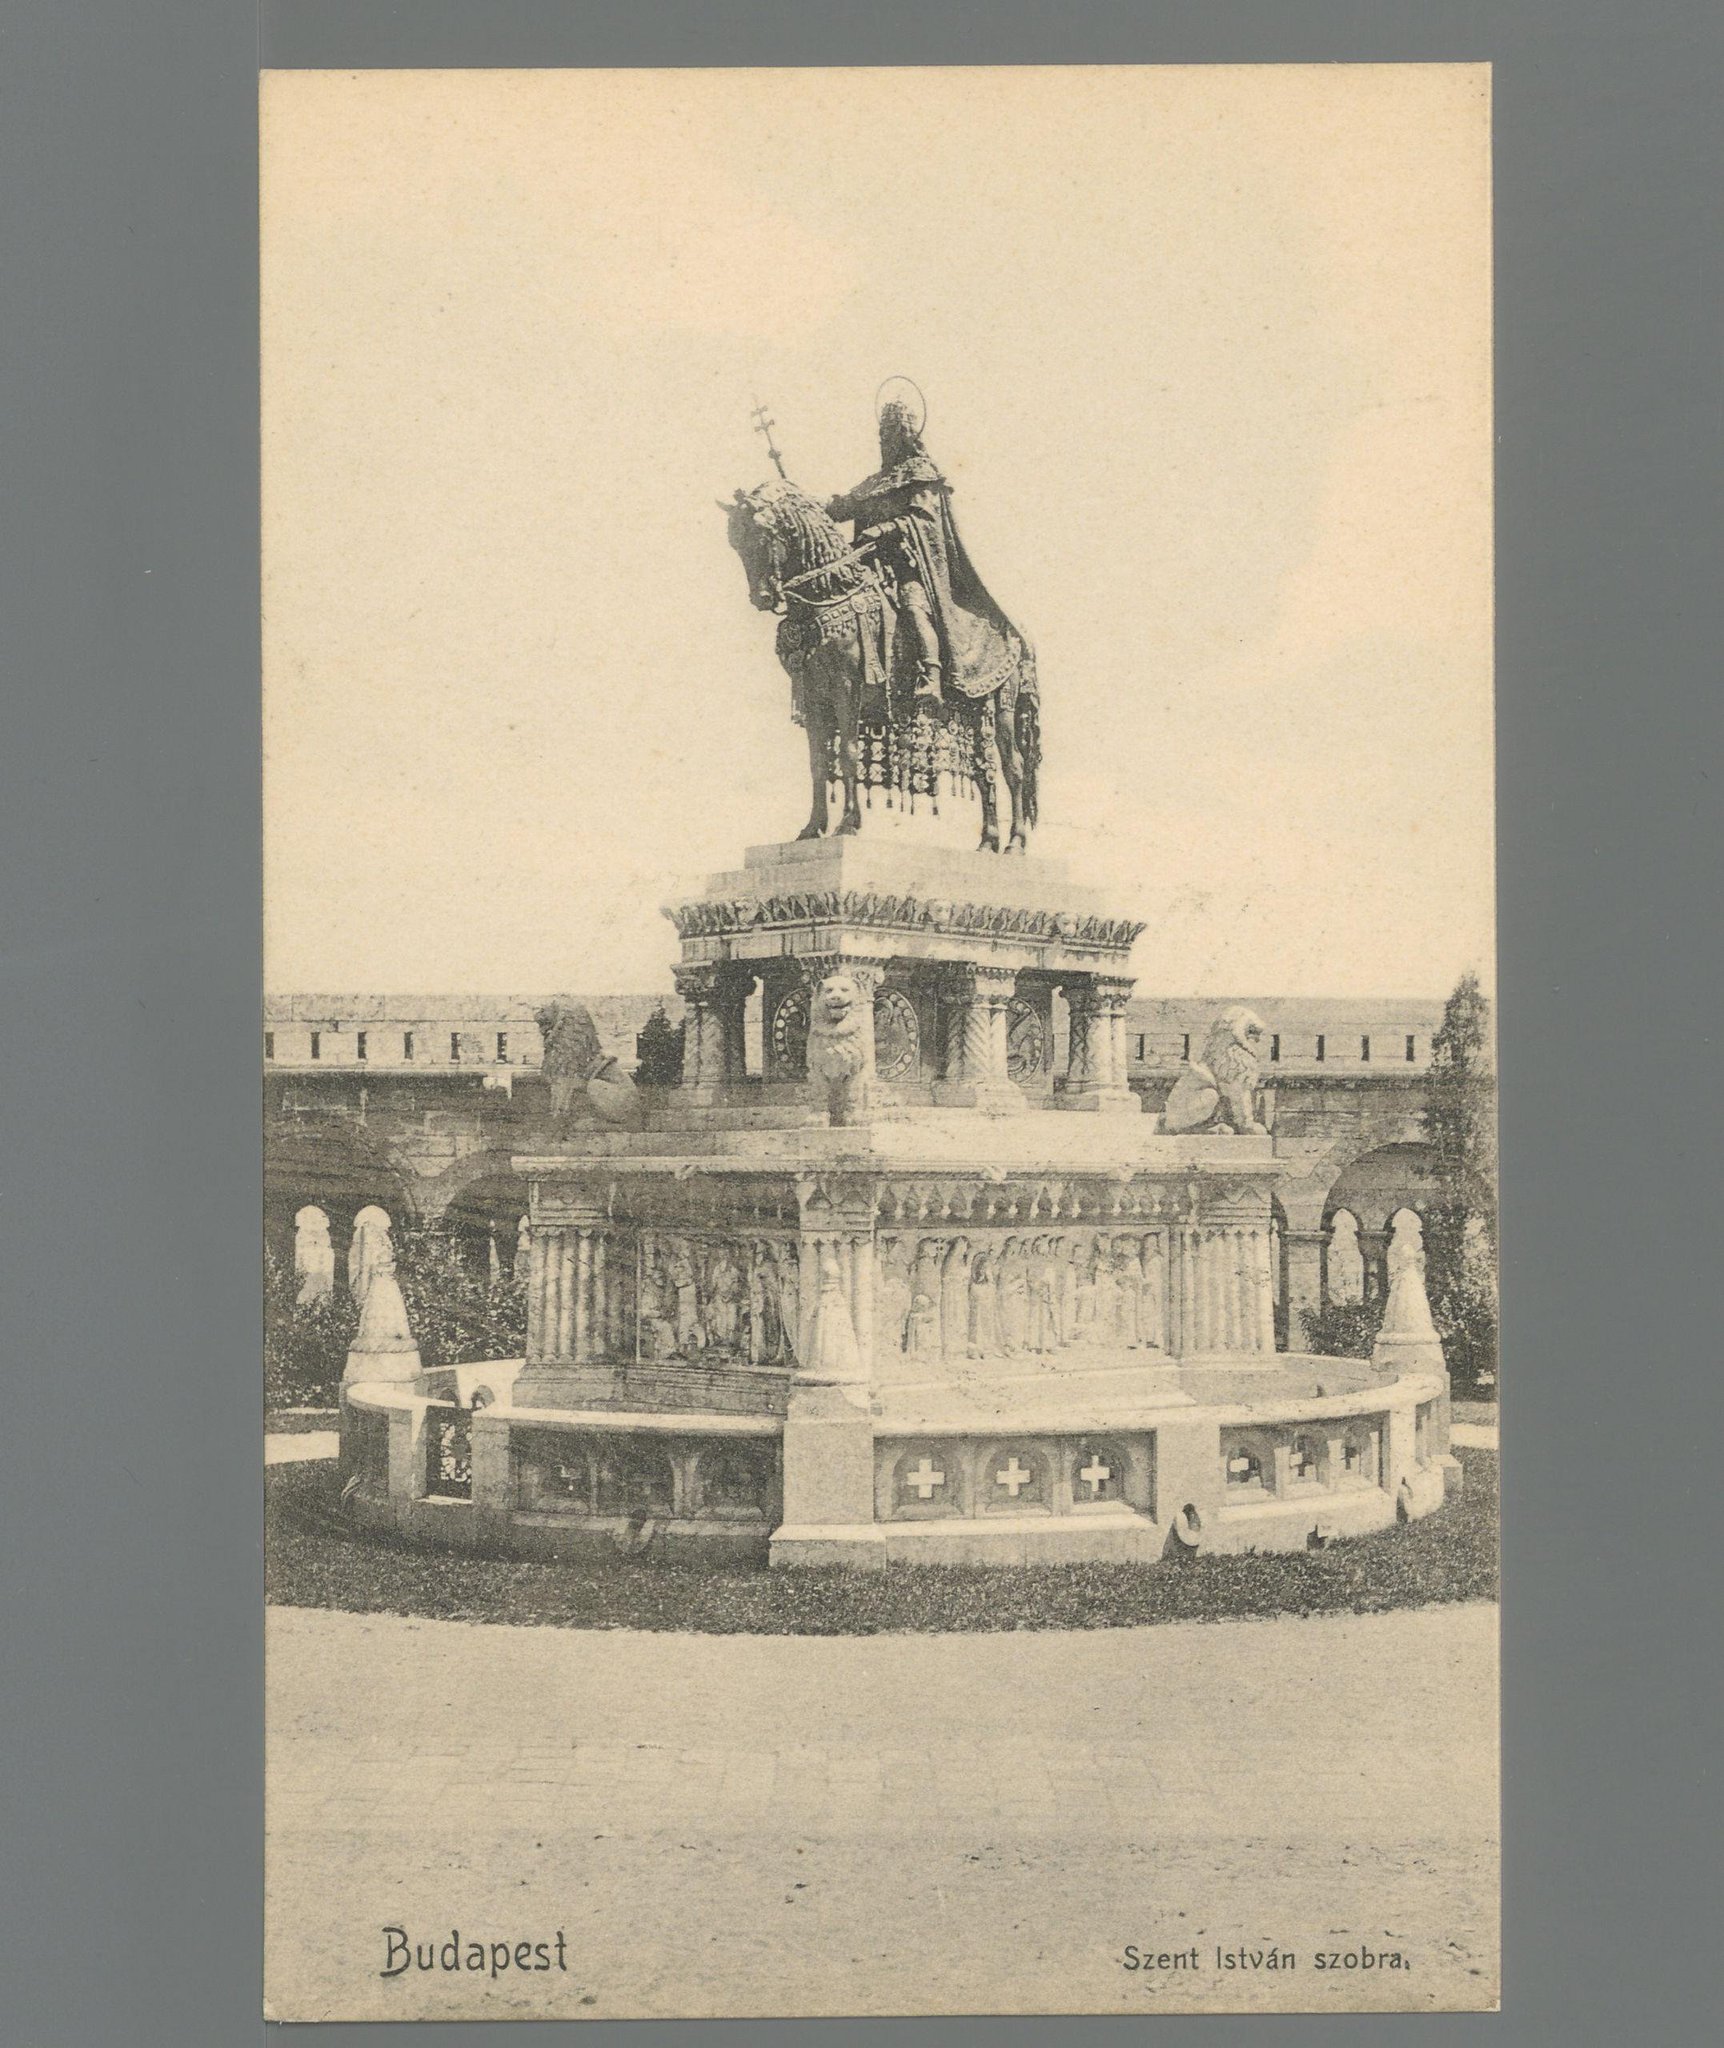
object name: photomechanical print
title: Budapest. Szent István szobra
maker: Anonymous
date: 1905-1930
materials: cardboard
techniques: photograph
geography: budapest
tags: monument, statue, king